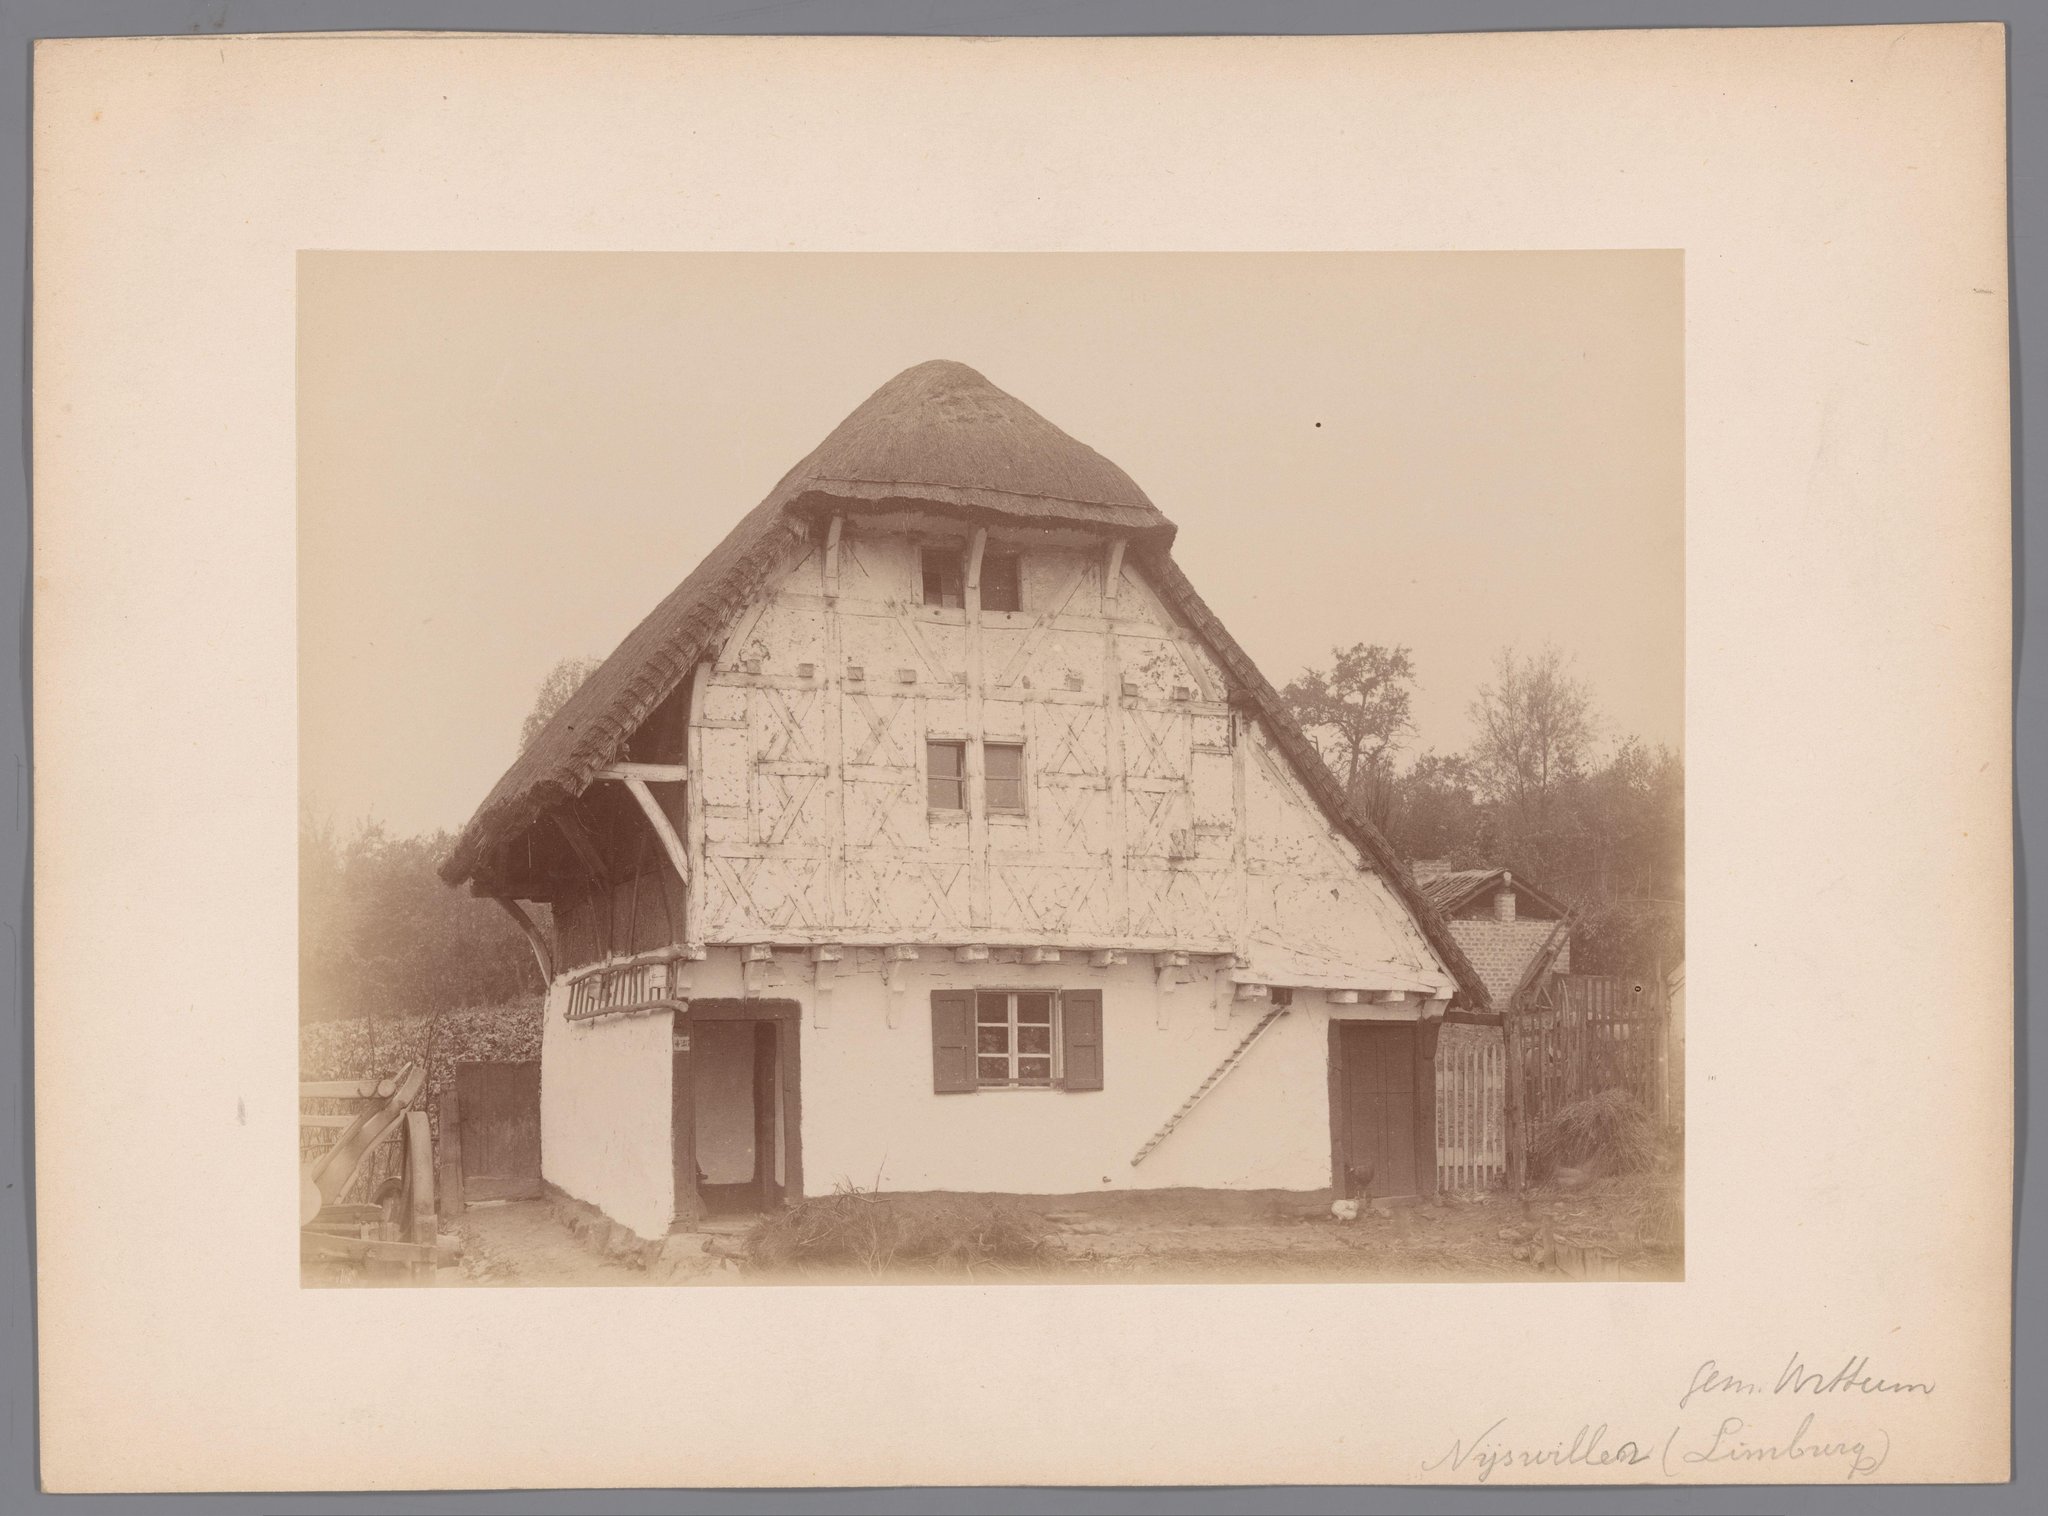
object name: photograph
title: Huis te Nijswiller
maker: anoniem (monumentenzorg)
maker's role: fotograaf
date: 1890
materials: cardboard, photographic support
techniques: albumen print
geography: nijswiller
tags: rural housing, e.g. country-house, villa, cottage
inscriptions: annotation: ‘Huis te Nijswiller/ Limburg/ oct 1890’, annotation: ‘gem. Wittum/ Nijswiller (Limbrug)’